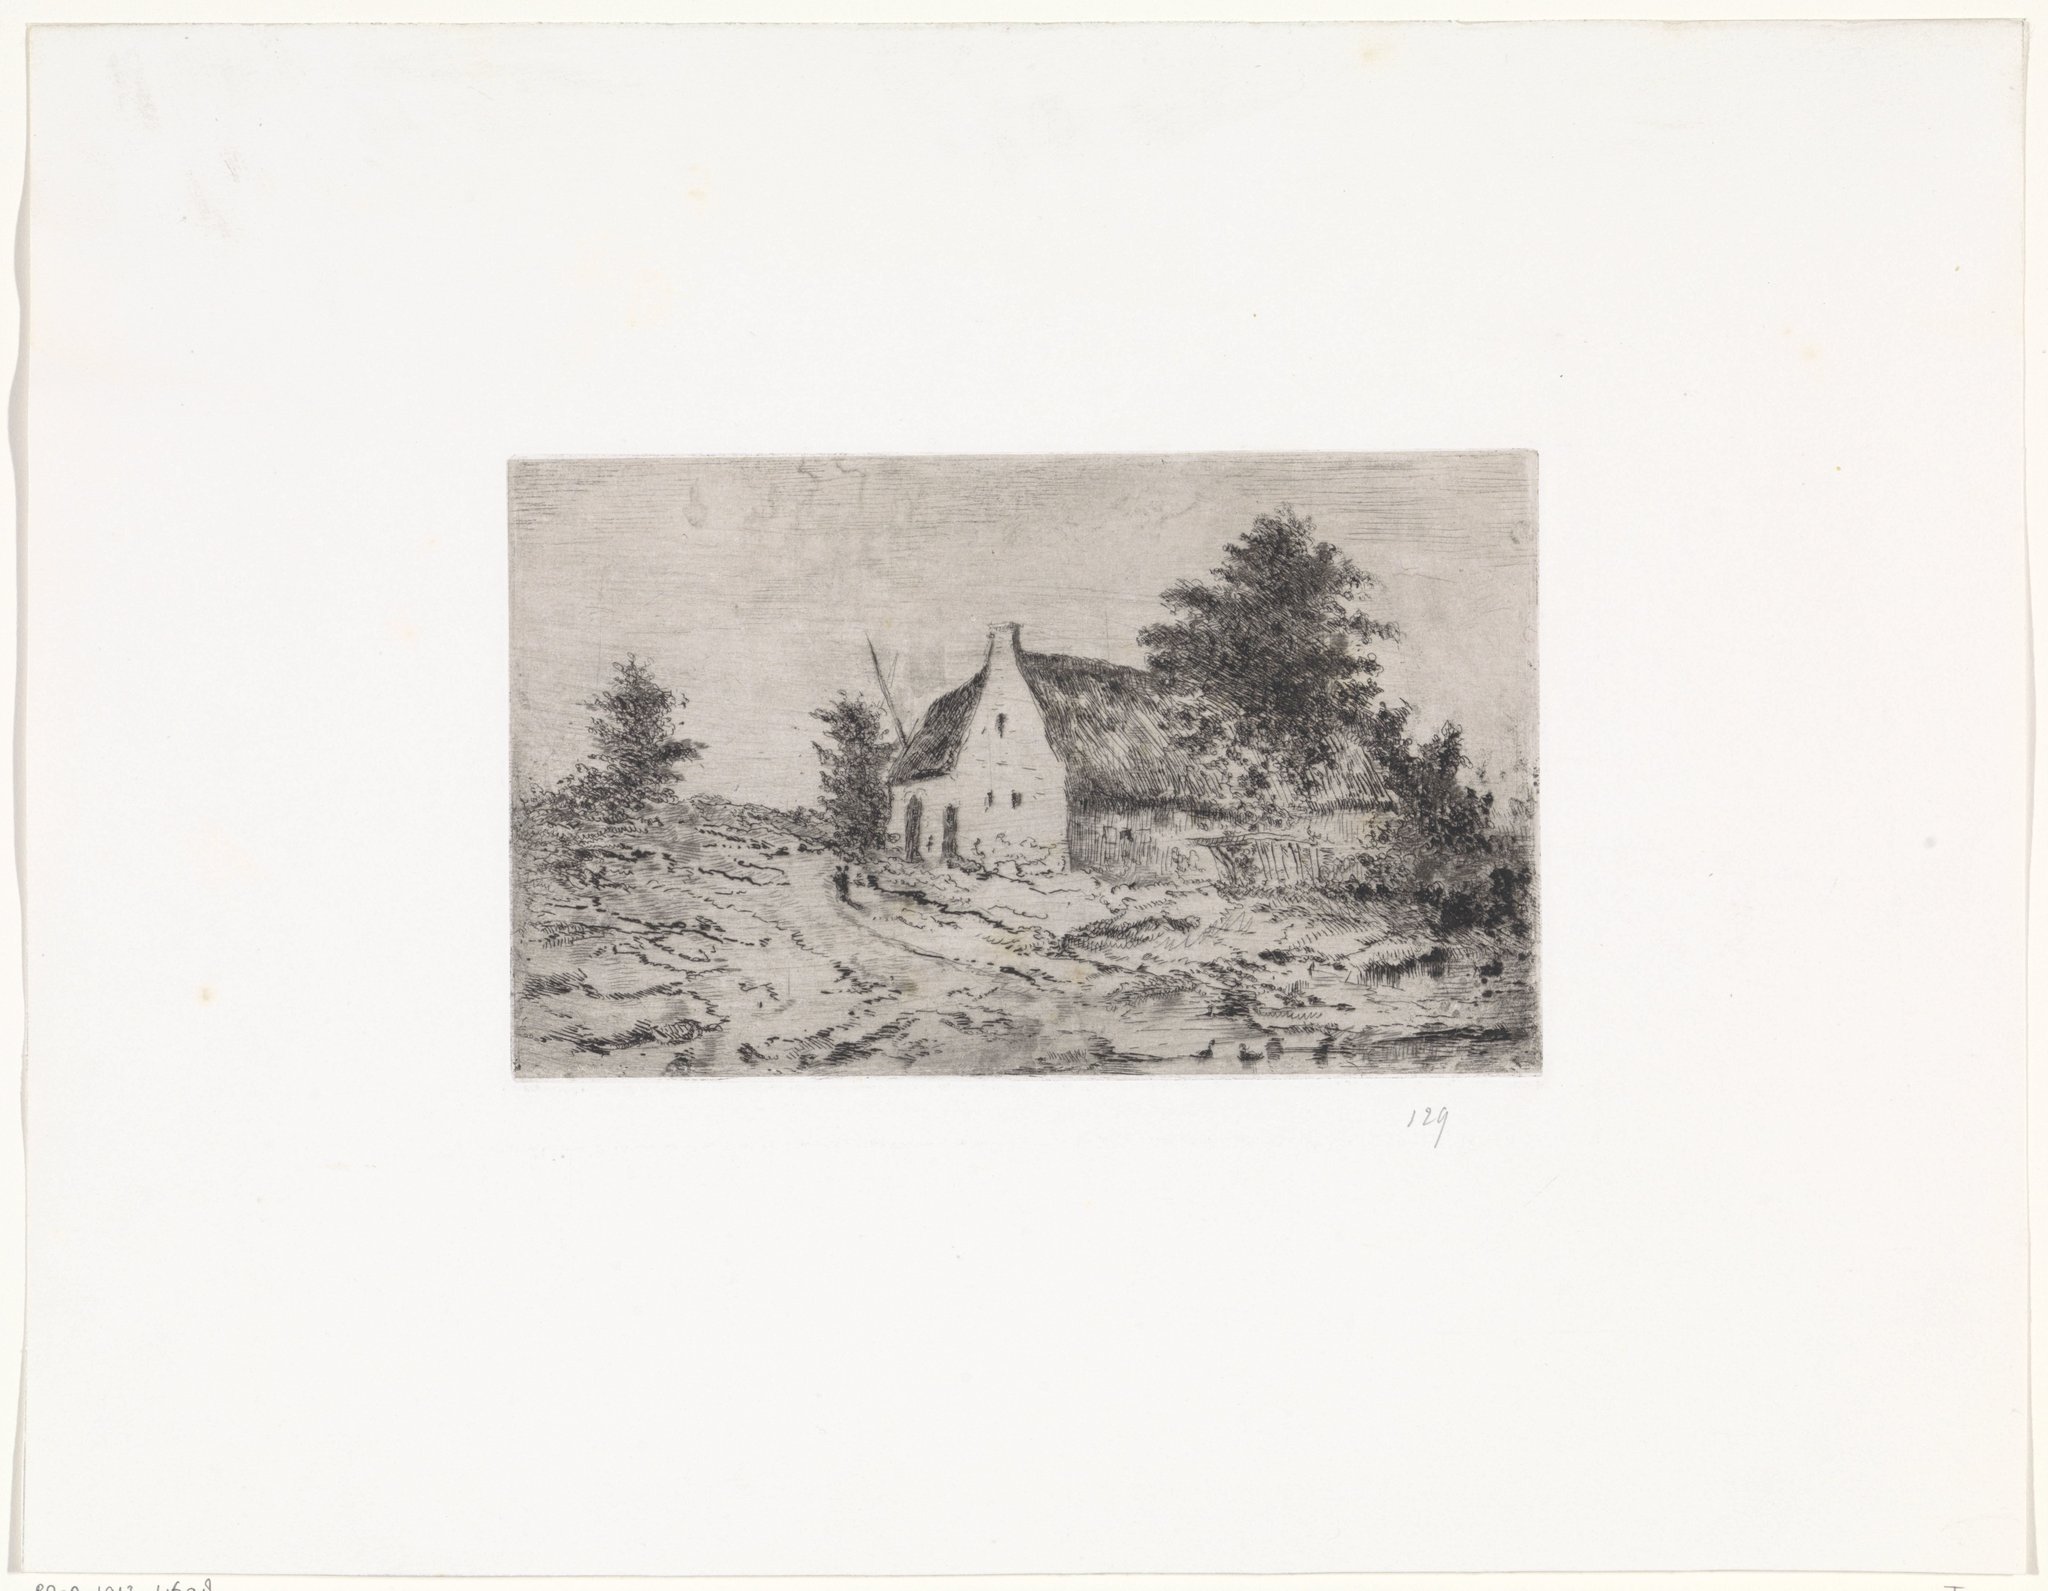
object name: print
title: Landschap met boerderij en vijver met eenden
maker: arnoud schaepkens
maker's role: print maker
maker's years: 1816-1904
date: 1855-1904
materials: paper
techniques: drypoint, etching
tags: fish pond (in garden), farm or solitary house in landscape, water-birds: duck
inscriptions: collector's mark: Lugt 2228